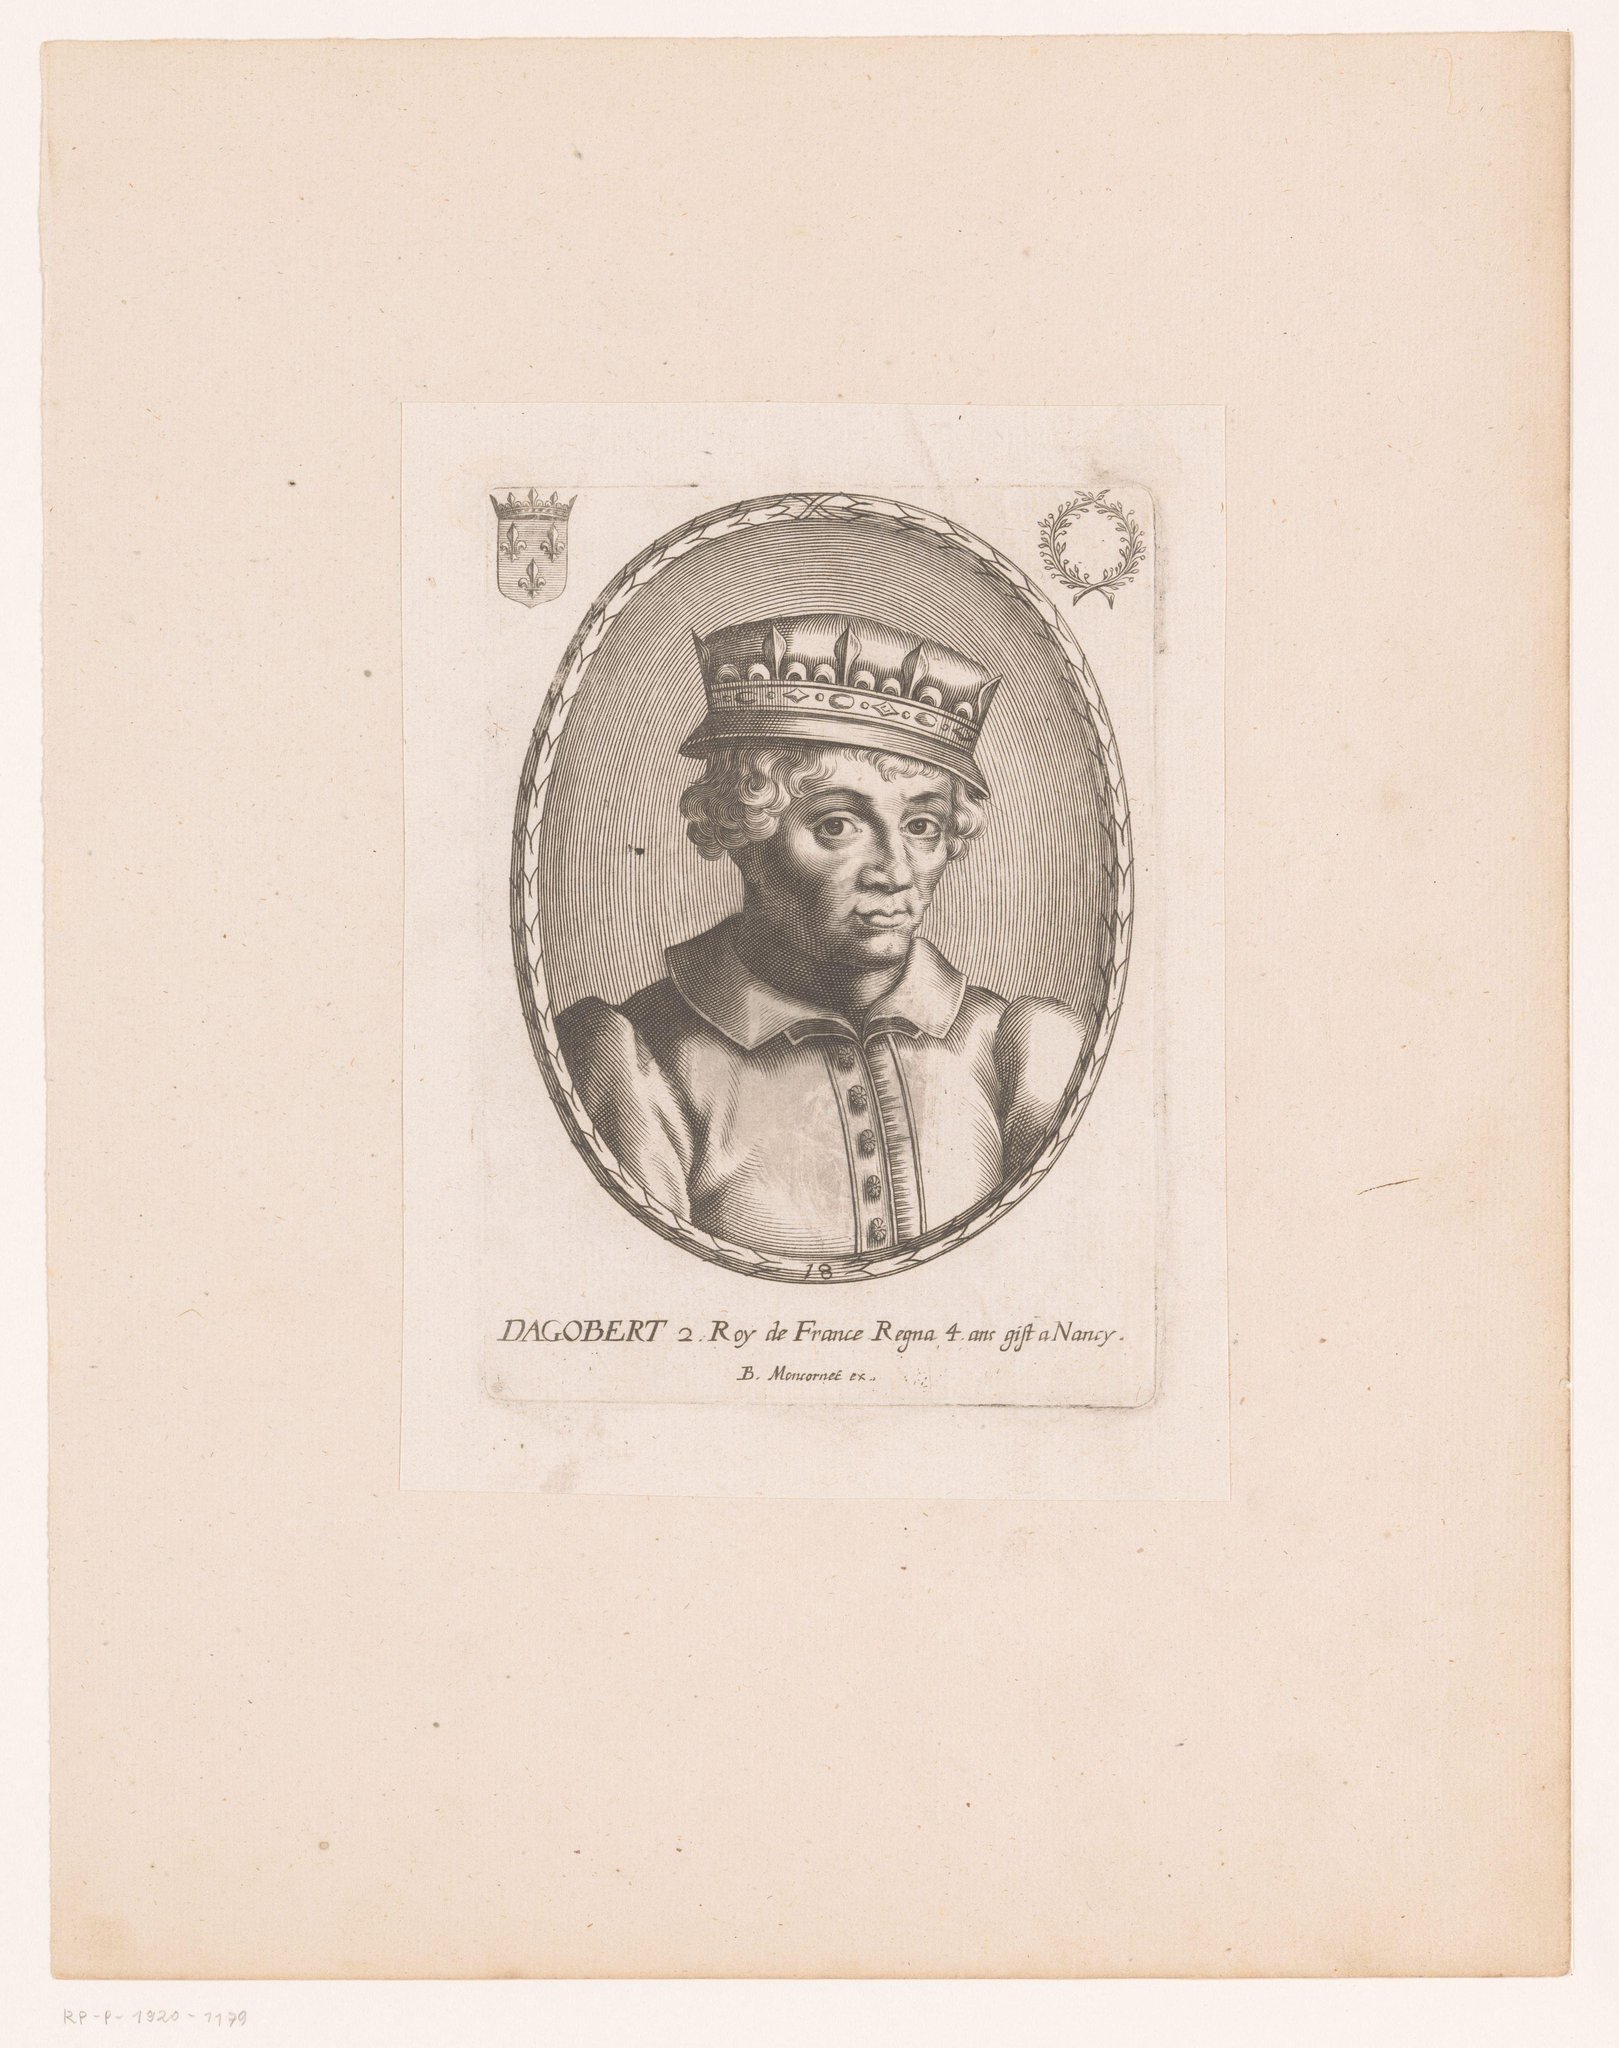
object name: print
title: Portret van Dagobert II, koning van Frankrijk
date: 1610-1668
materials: paper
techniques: engraving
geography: paris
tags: historical persons, king, armorial bearing, heraldry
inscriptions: collector's mark: Lugt 2228